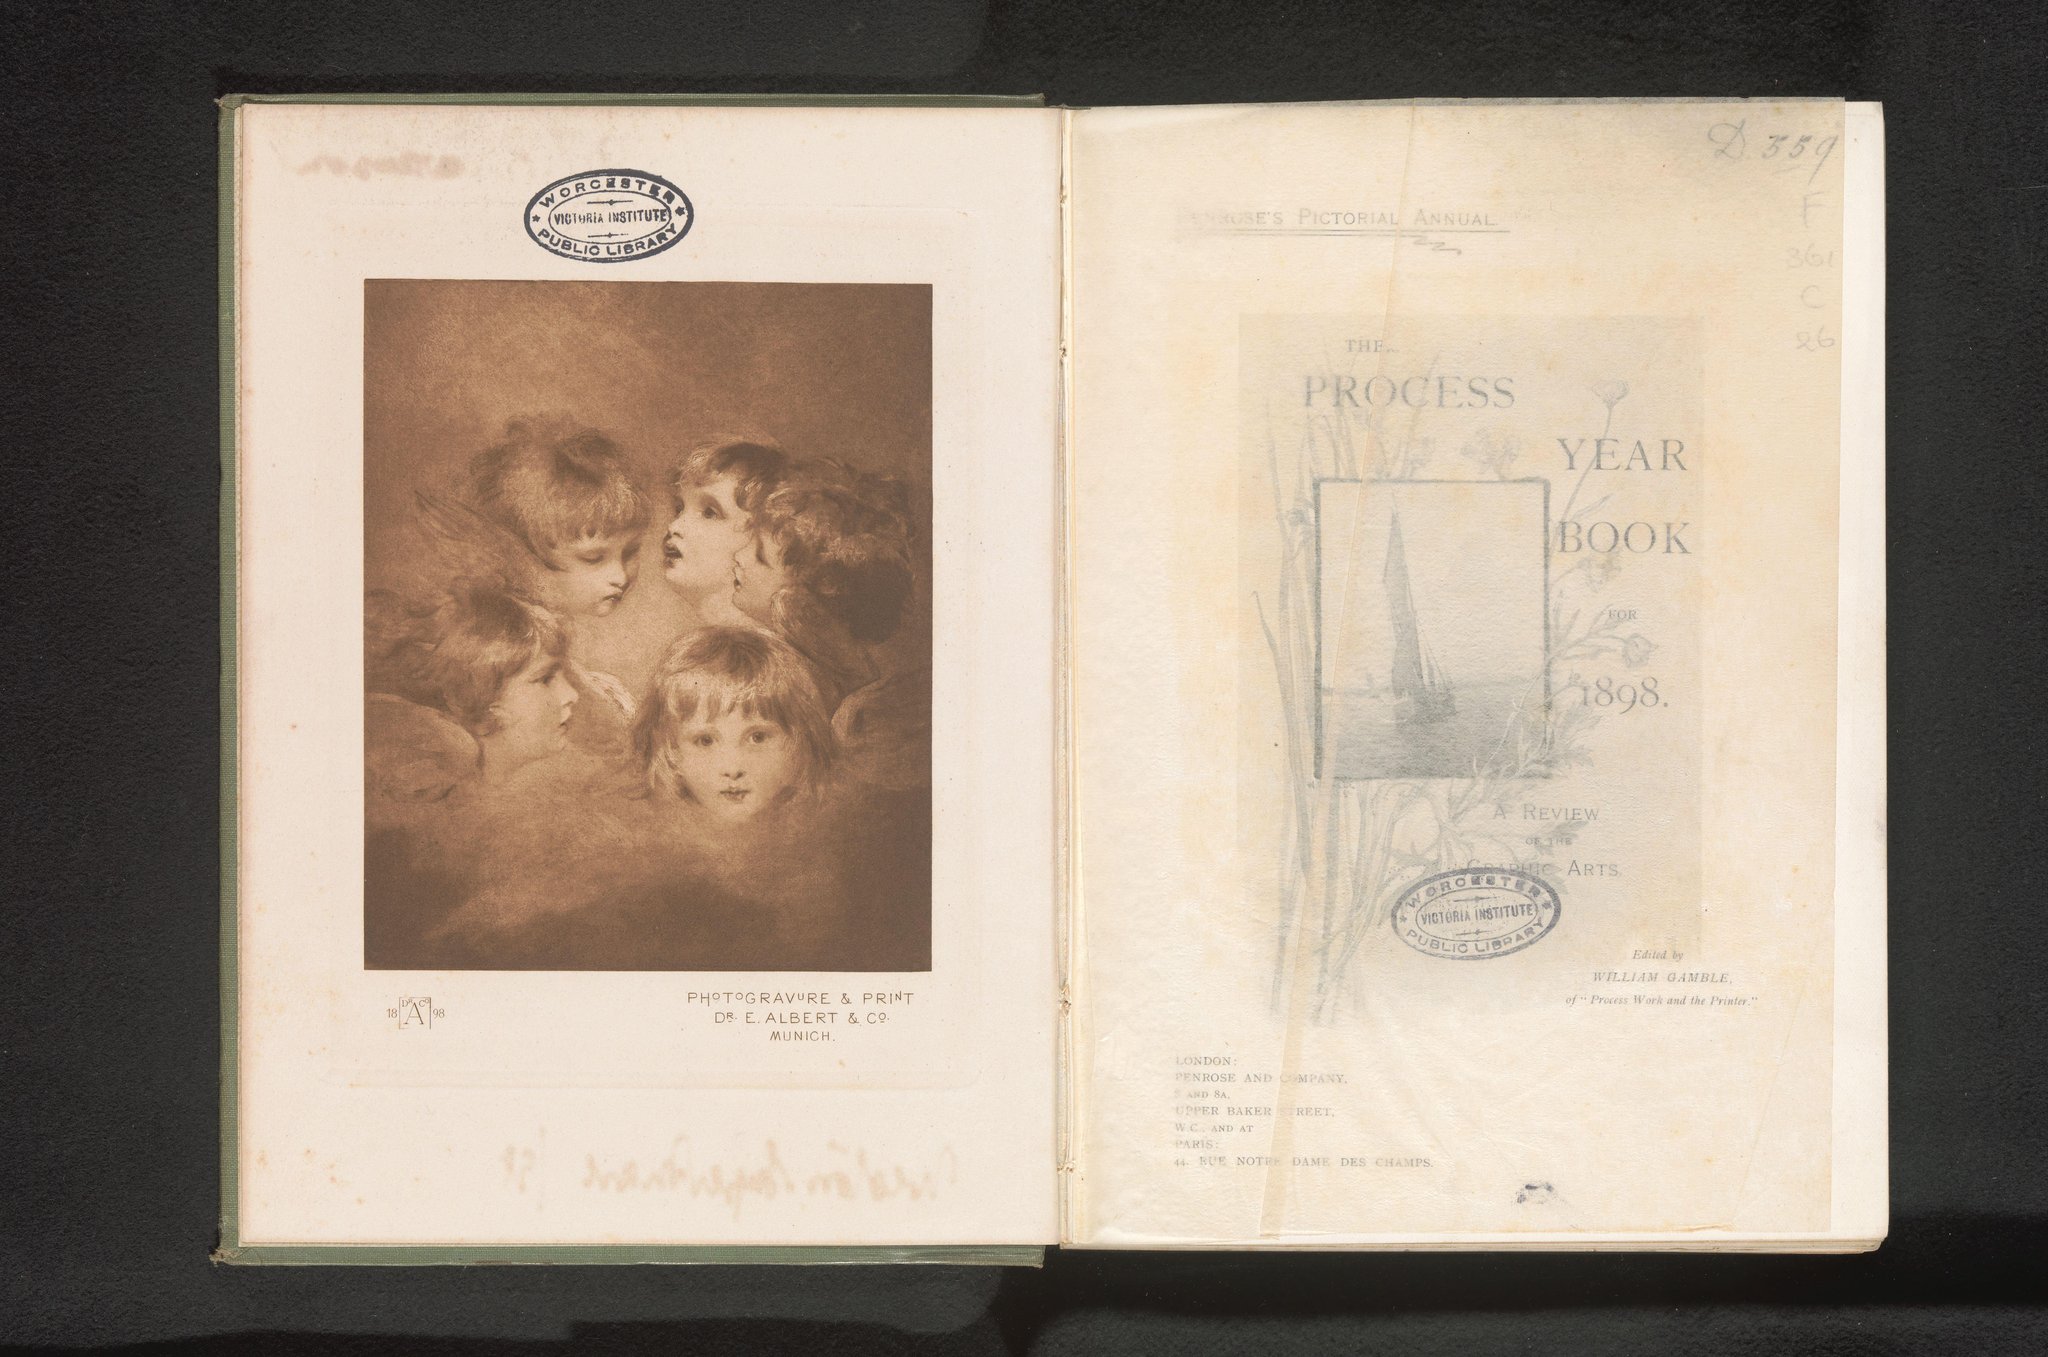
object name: page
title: Reproductie van een ontwerp van vijf gezichten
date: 1893-1898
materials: paper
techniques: photoaquatint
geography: munich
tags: head (human)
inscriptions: monogram: ‘Dr A Co 1898’, collector's mark: ‘Worcester Public Library/ Victoria Institute’